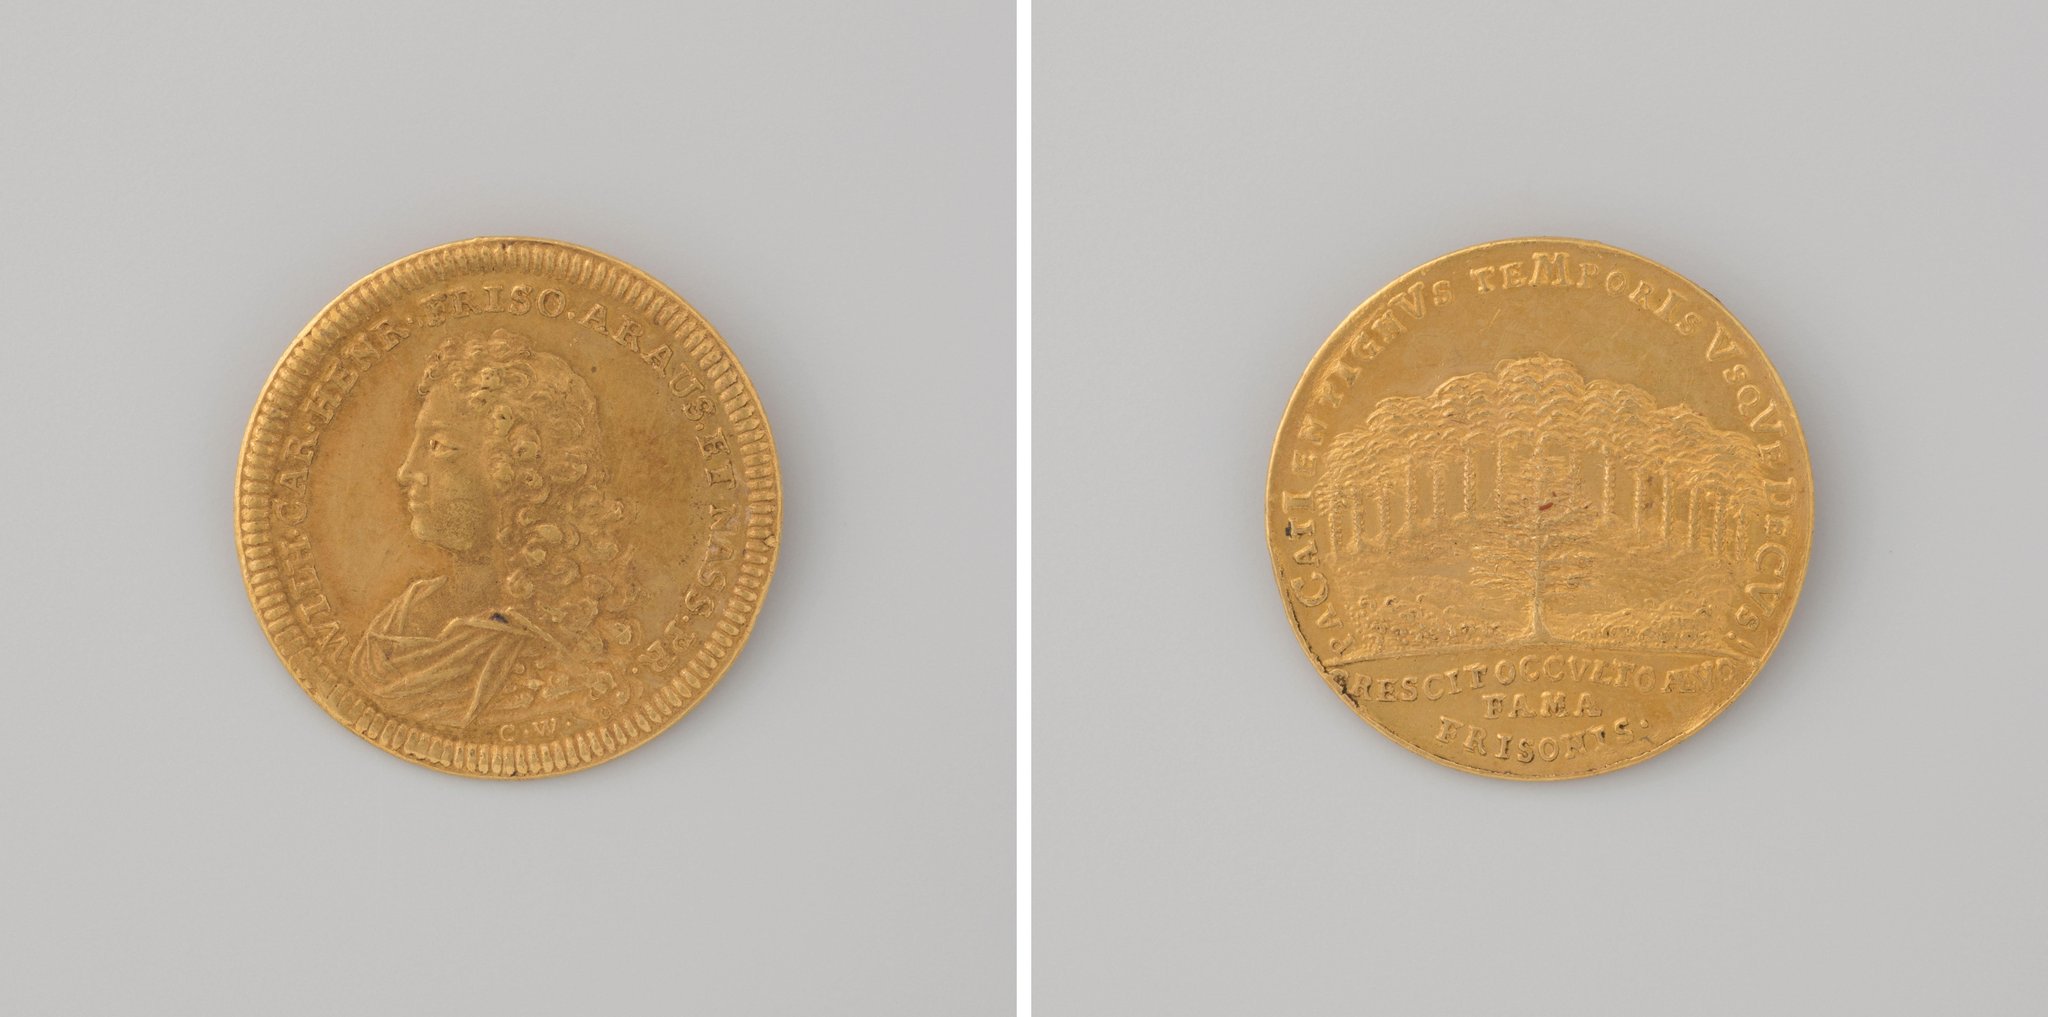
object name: jeton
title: Willem Karel Hendrik Friso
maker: christian wermuth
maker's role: medailleur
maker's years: 1661-1739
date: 1722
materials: gold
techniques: striking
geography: gotha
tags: the hague, willem iv (prins van oranje-nassau)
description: Gouden penning. Voorzijde: borststuk man binnen omschrift. Keerzijde: jonge boom, op achtergrond rij grote bomen binnen omschrift; afsnede: opschrift